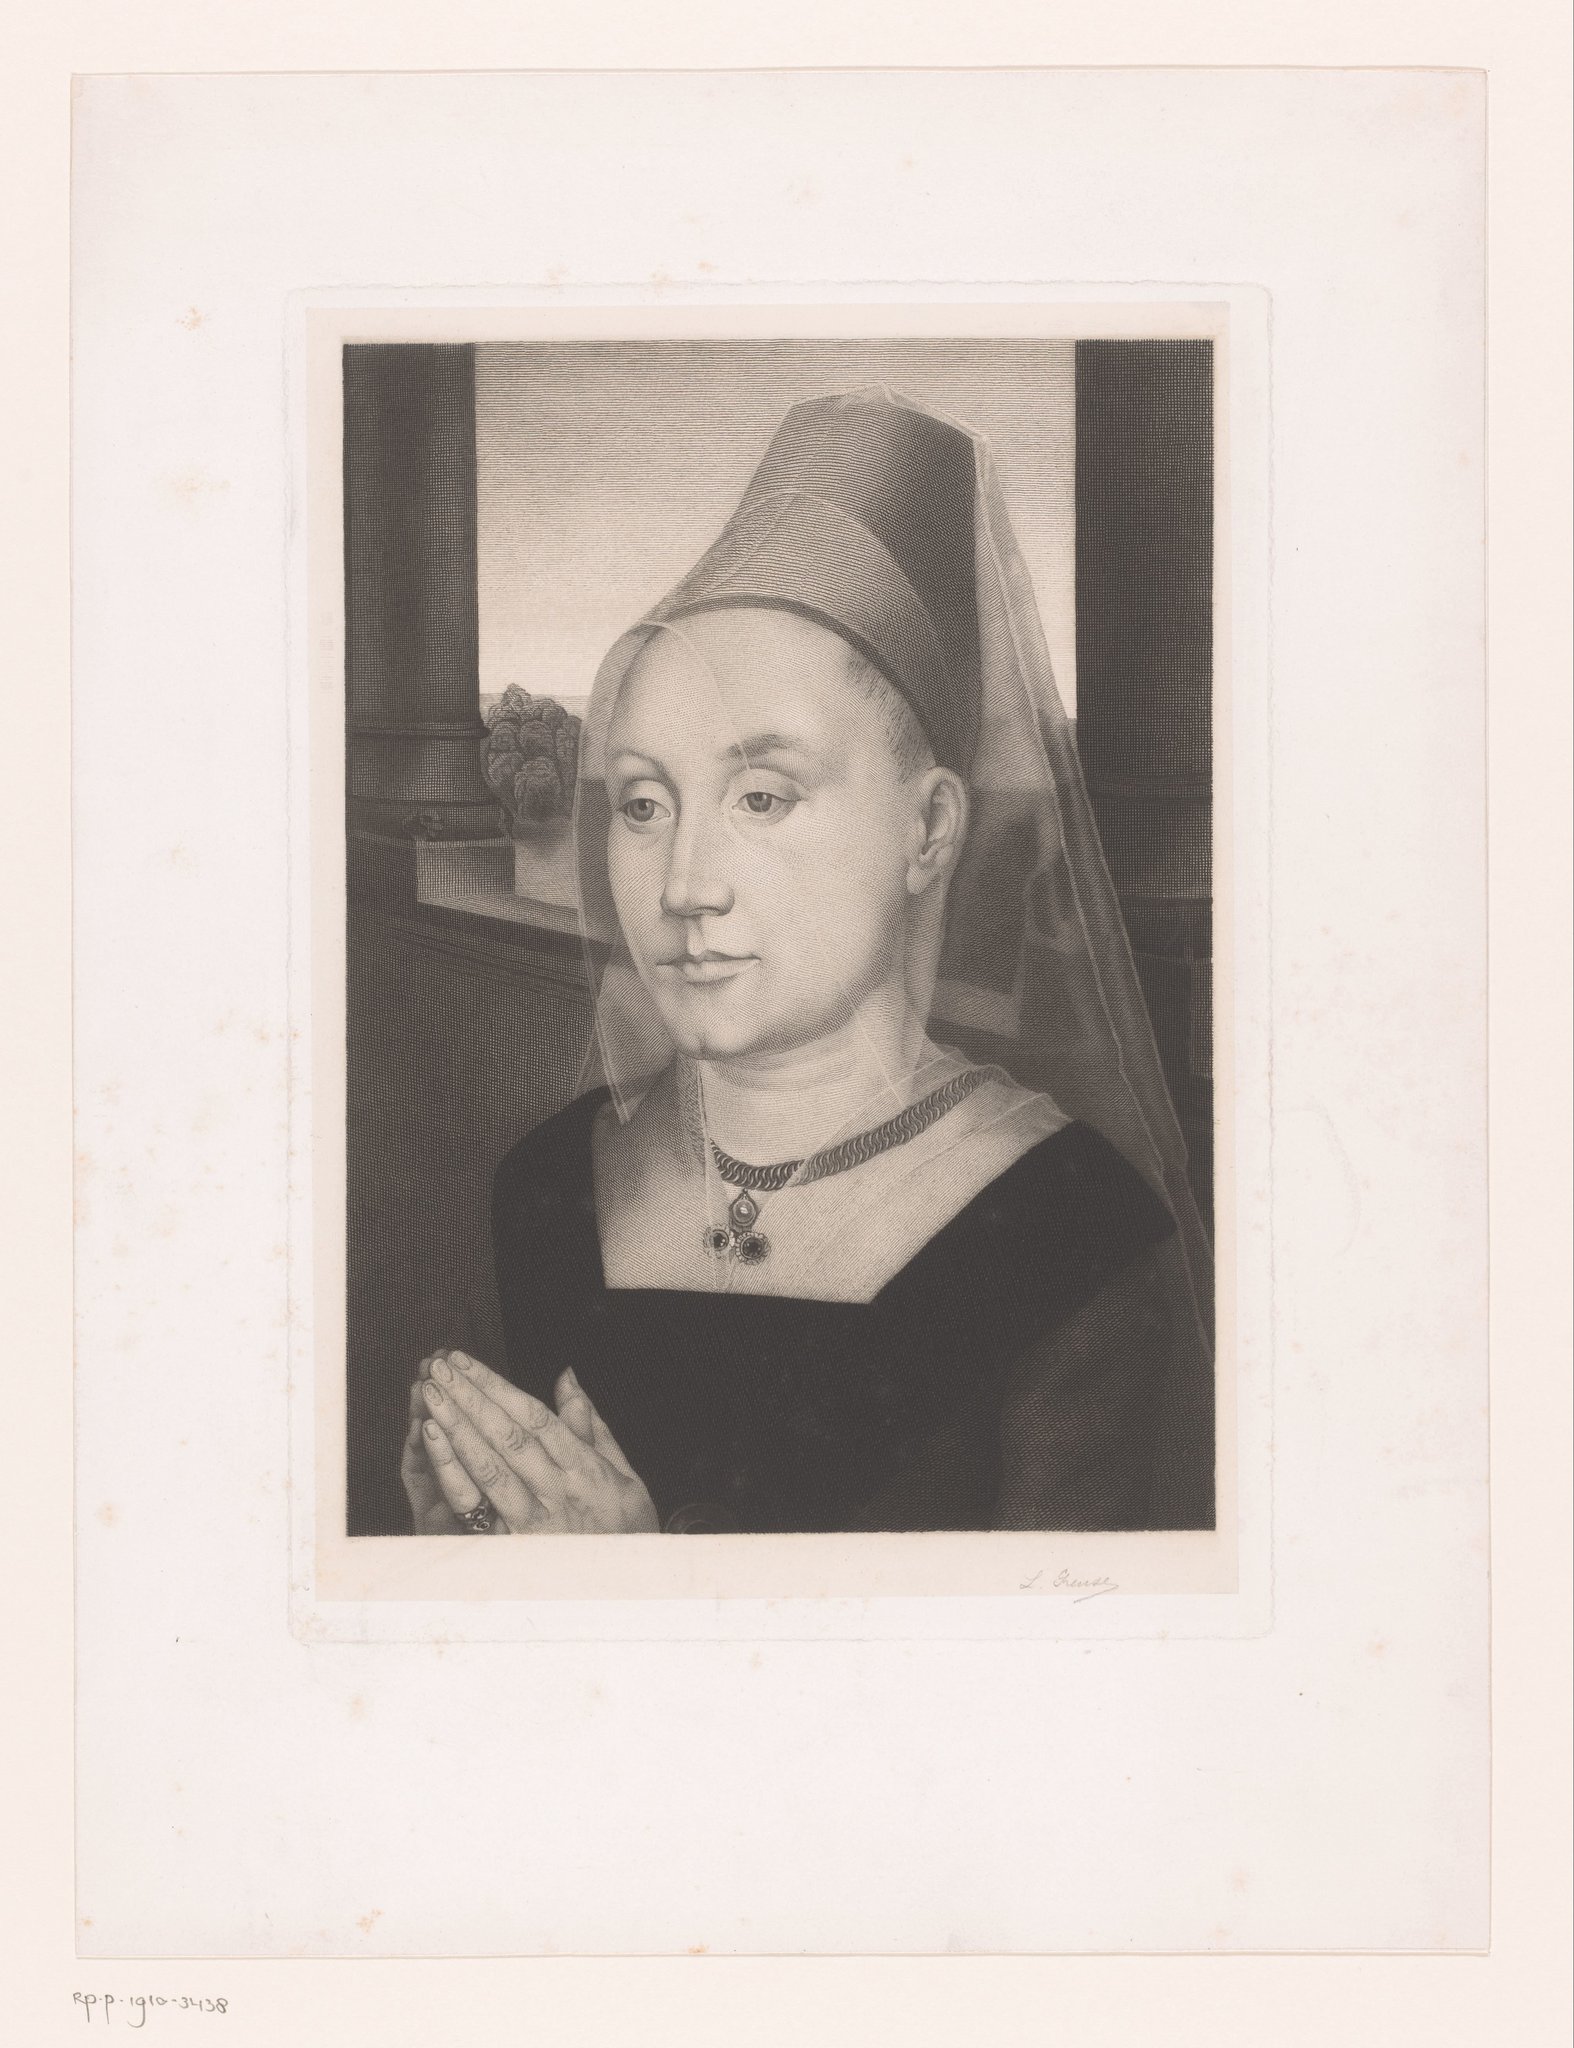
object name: print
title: Portret van Barbara van Vlaendenbergh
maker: louis joseph greuse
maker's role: print maker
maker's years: 1863-1950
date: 1885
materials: paper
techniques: engraving, etching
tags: historical persons - bb - woman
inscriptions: collector's mark: Lugt 2228, annotation: ‘La femme du Bourgemestre de Bruges d'apres Memling par L. Greuze’